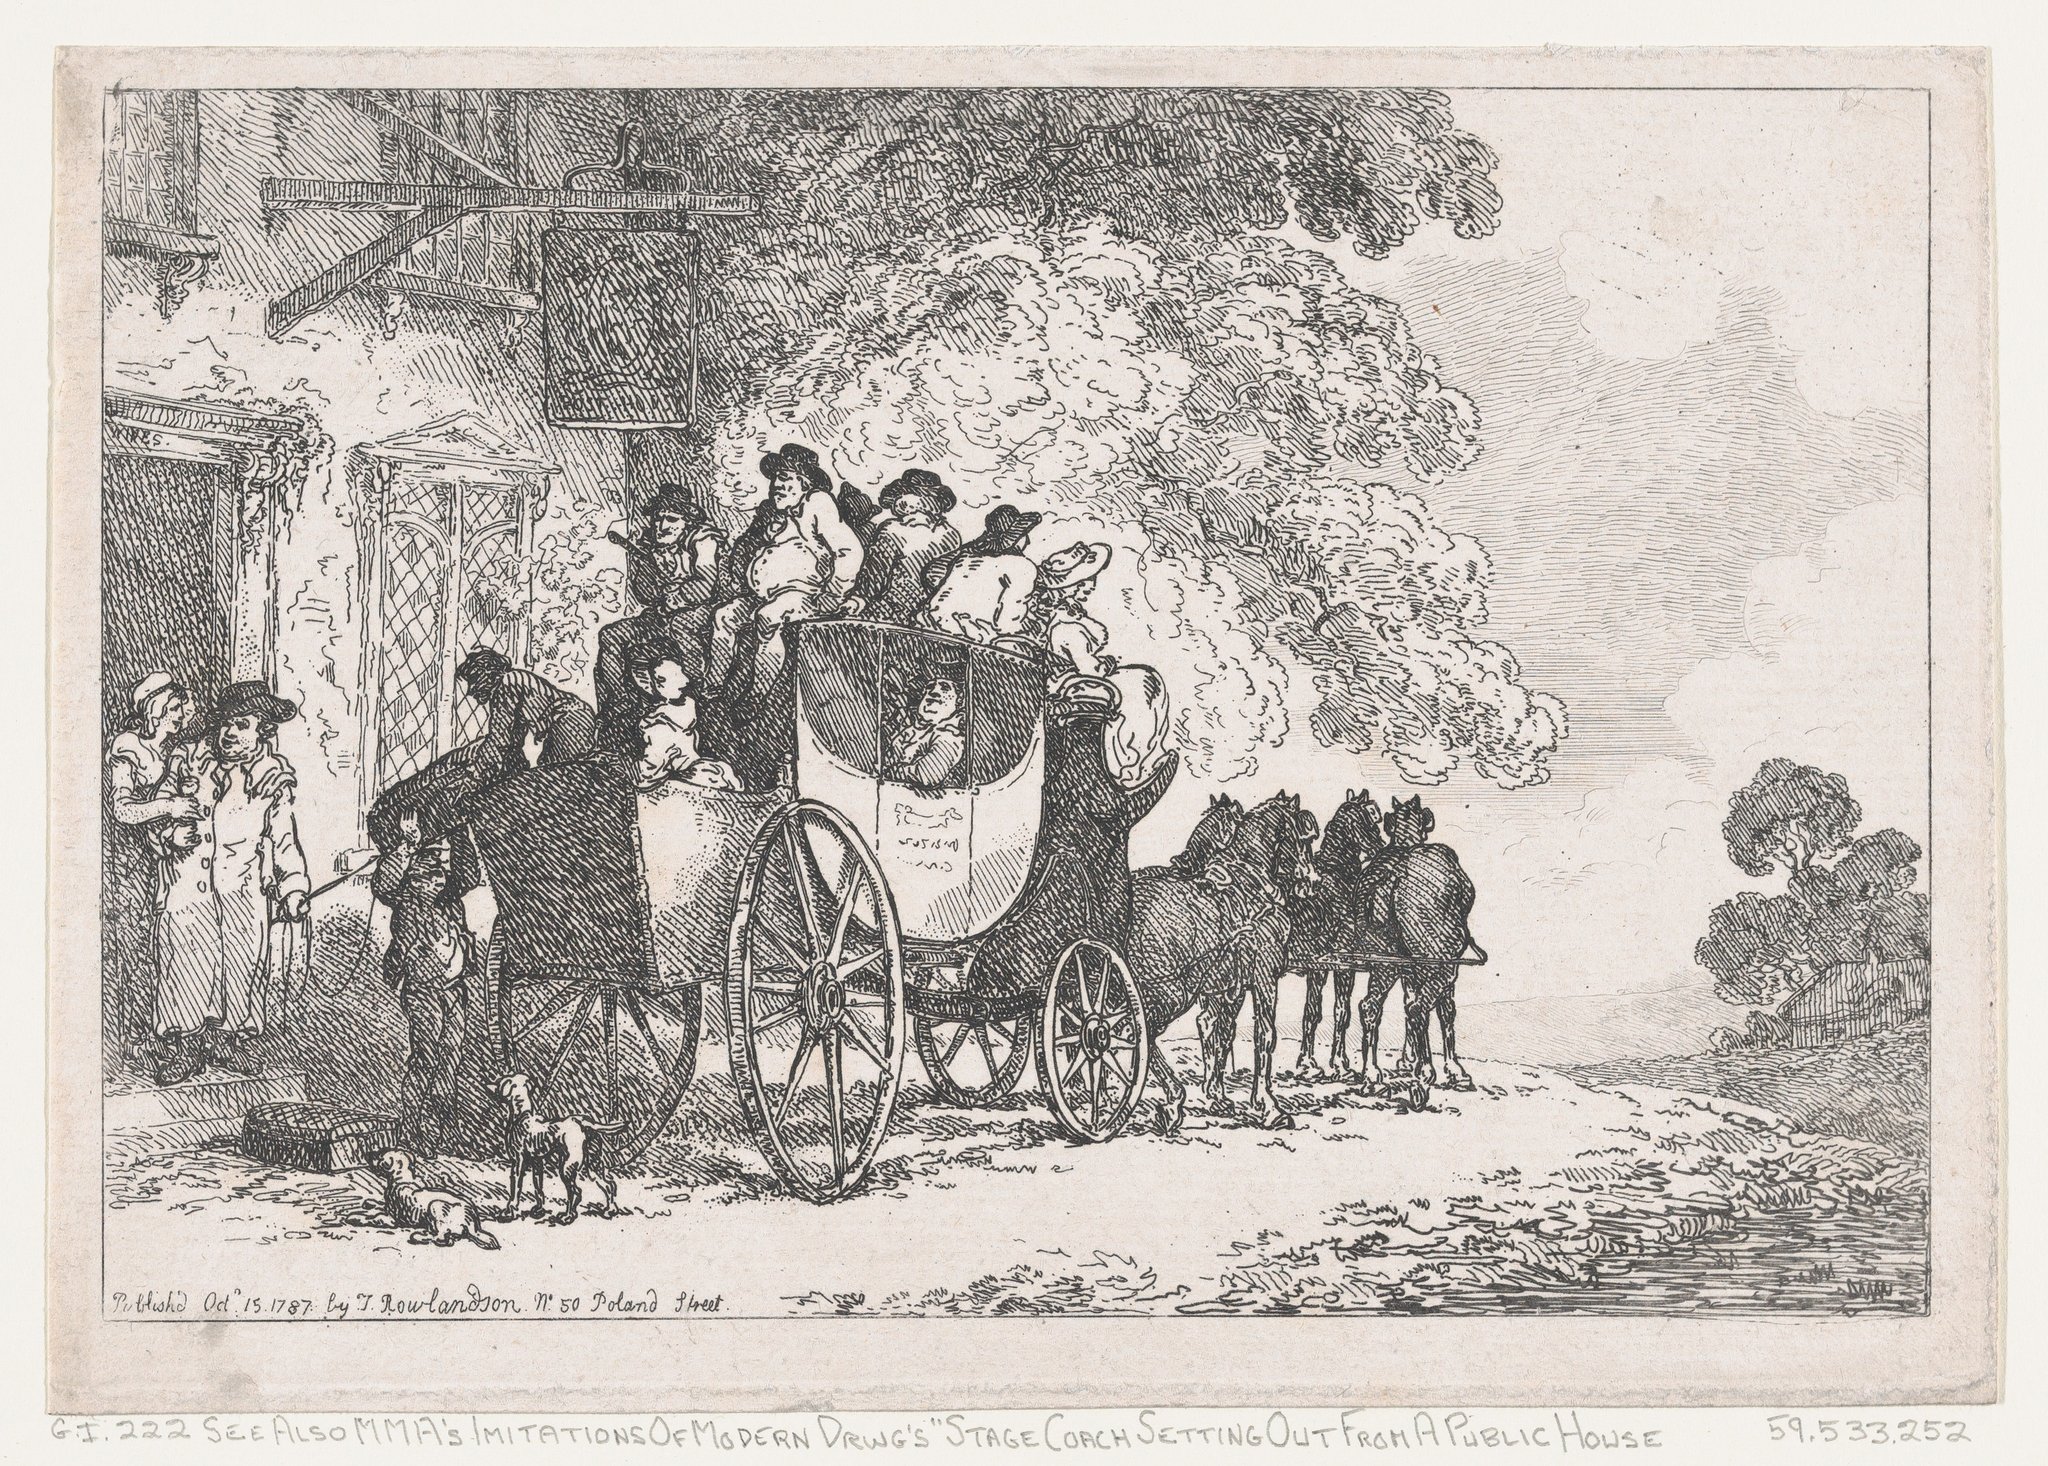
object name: print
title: A Laden Stage Coach Outside a Post House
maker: thomas rowlandson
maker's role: artist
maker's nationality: british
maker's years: 1757-1827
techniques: etching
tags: men,women,dogs,horses,carriages